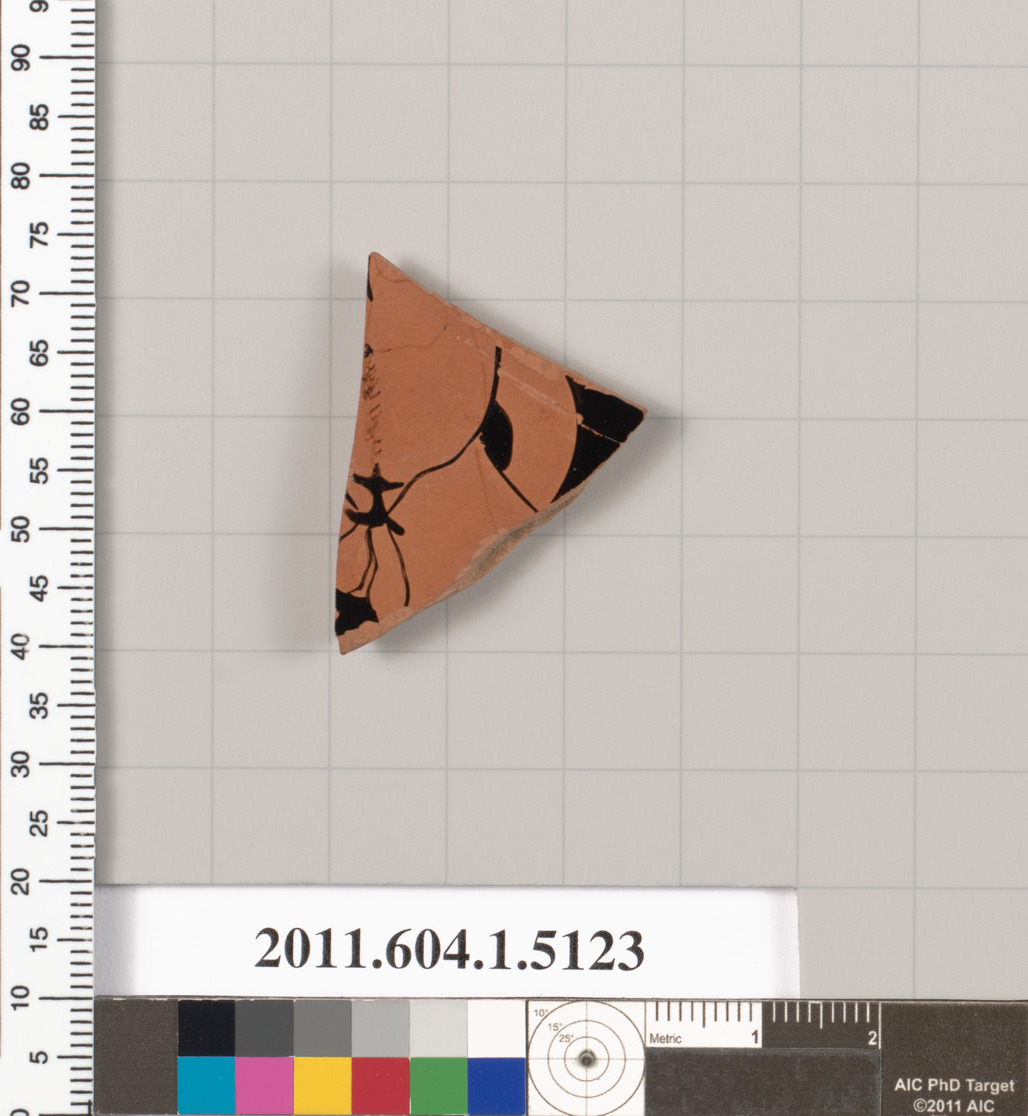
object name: kylix fragment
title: Terracotta fragment of a kylix (drinking cup)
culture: greek, attic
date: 490-480 BCE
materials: terracotta